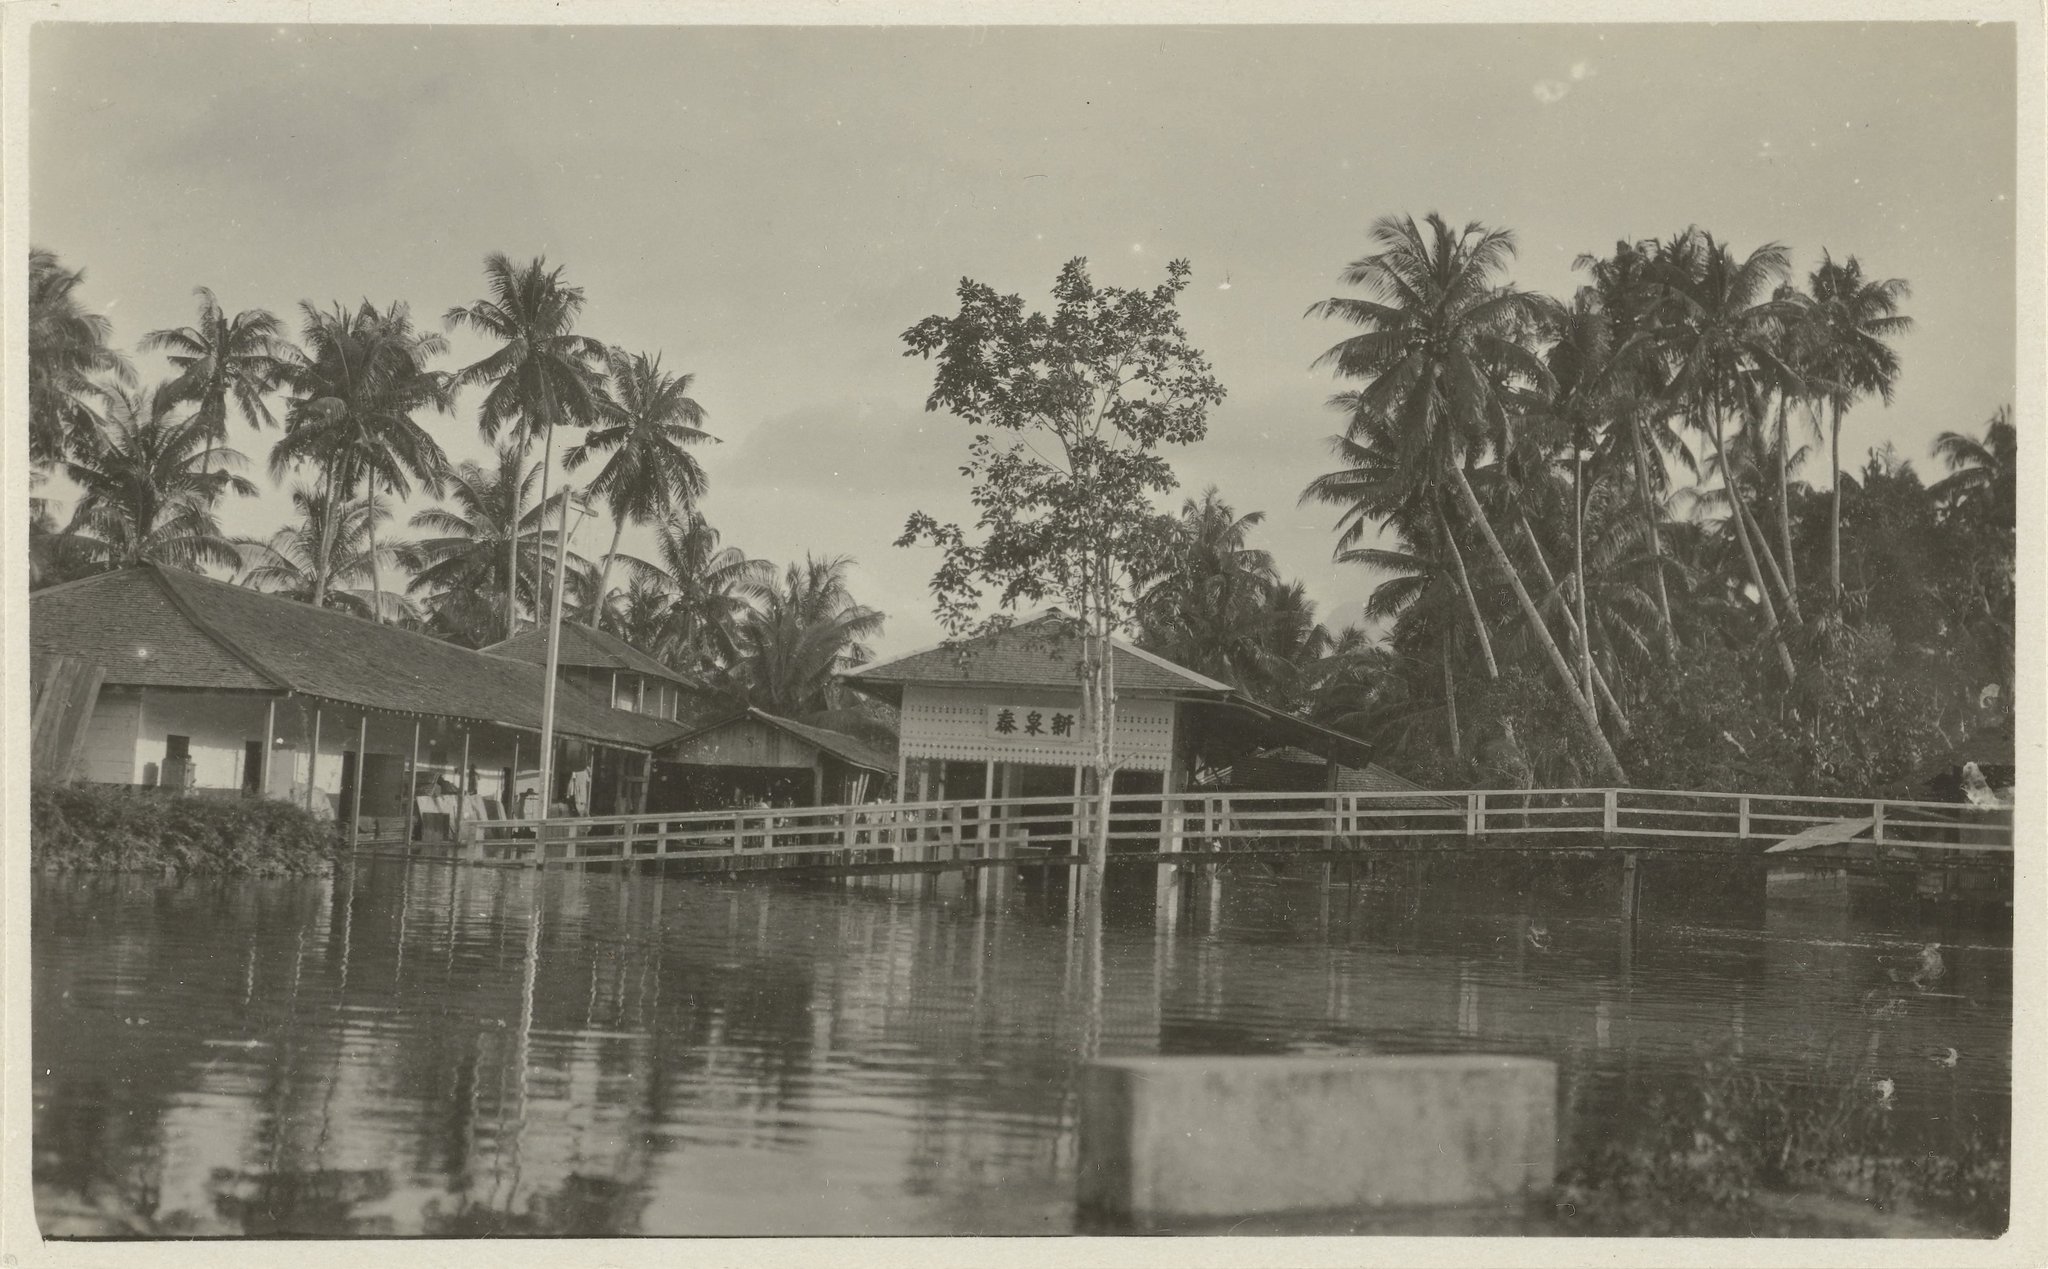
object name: photograph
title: Buiten de oevers getreden water in Singkawang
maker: Anonymous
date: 1920-1940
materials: photographic support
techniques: gelatin silver print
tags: borneo